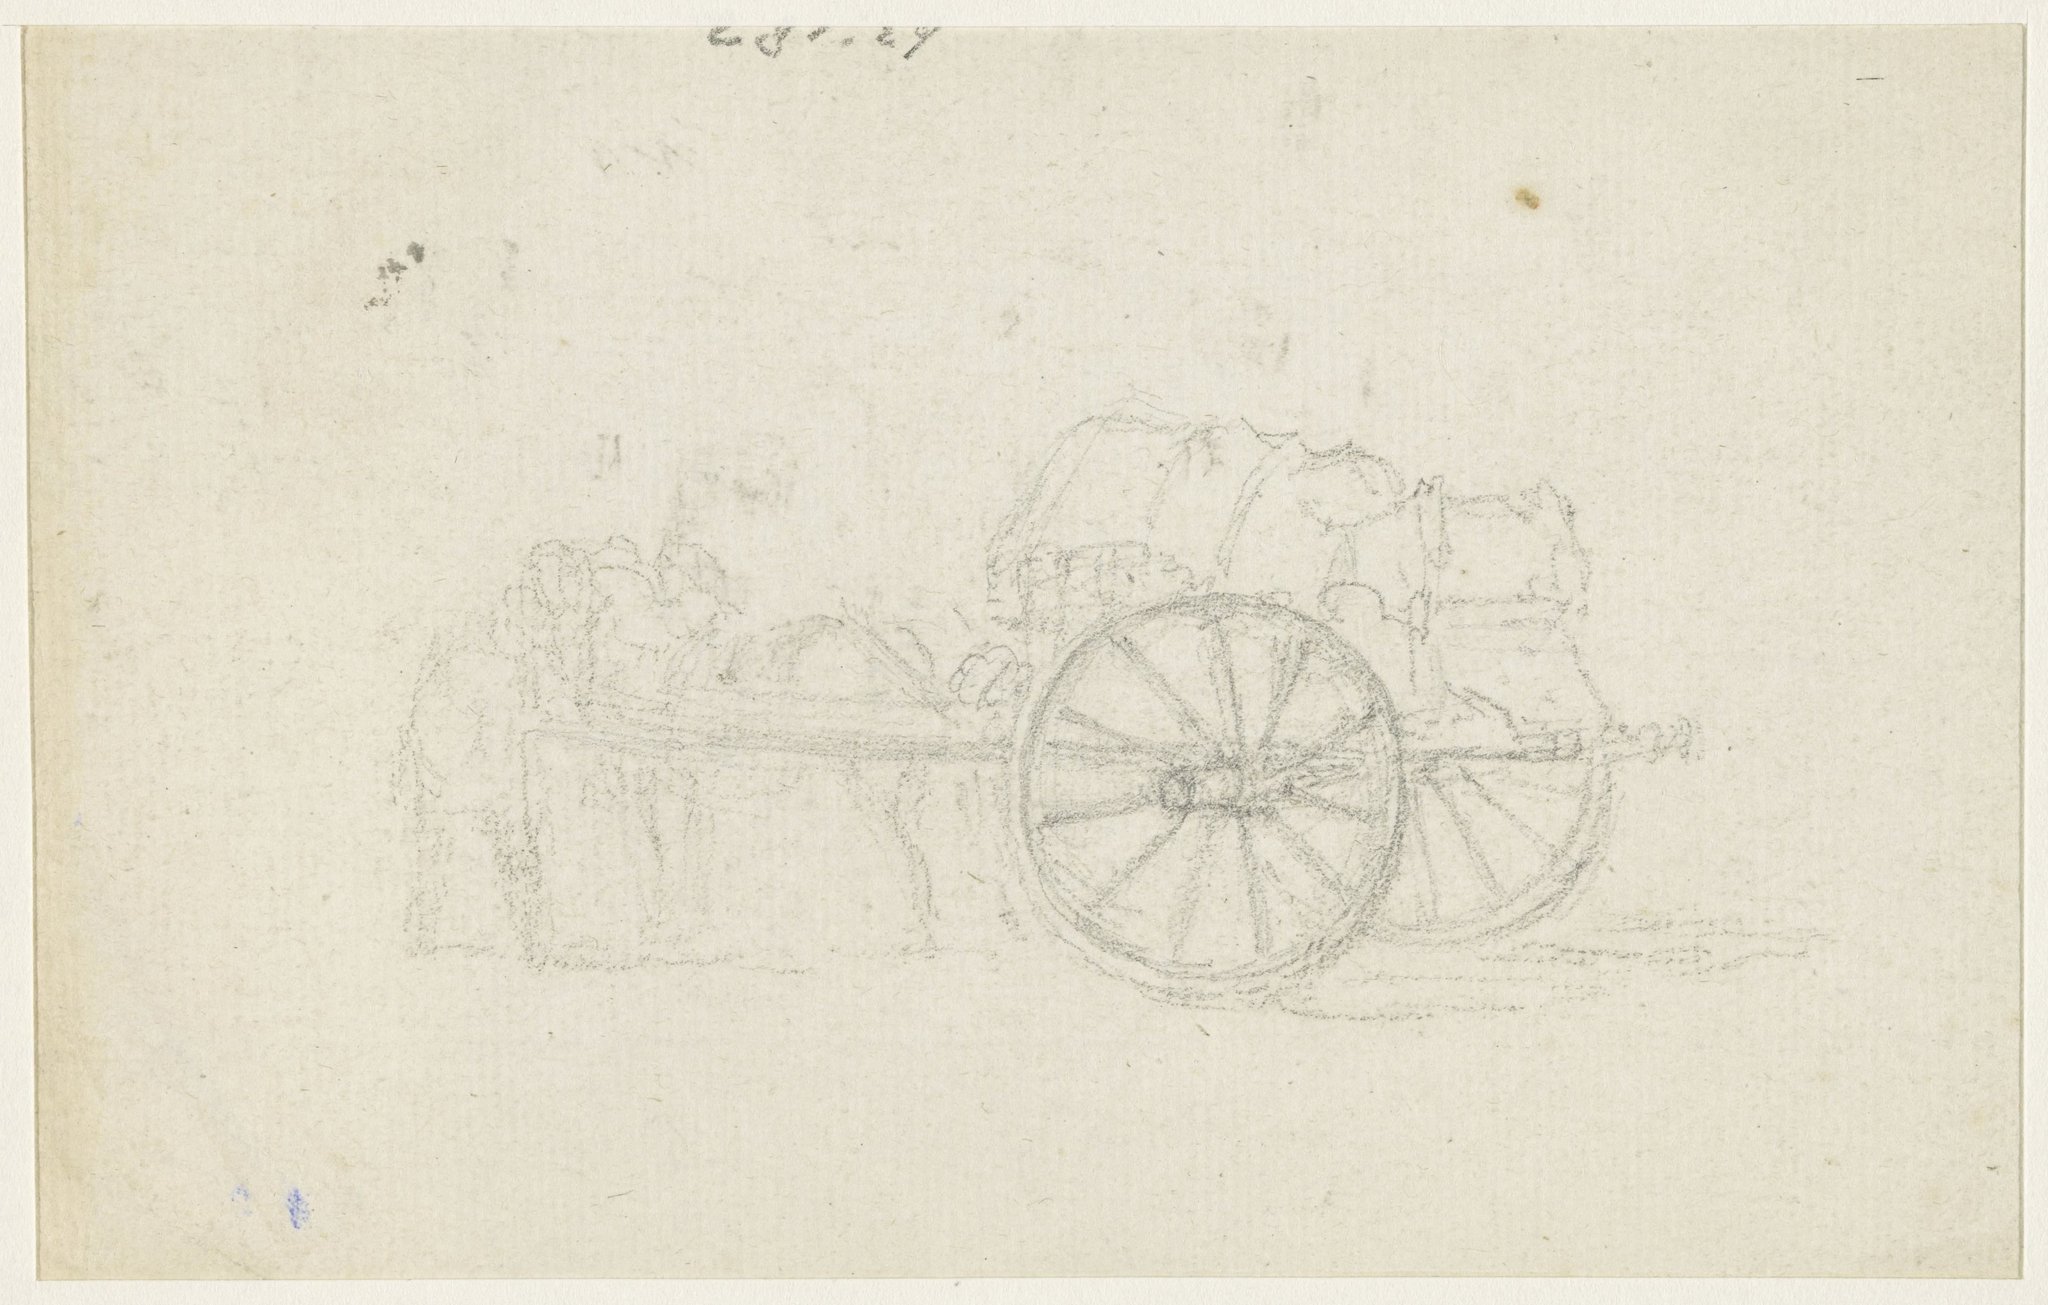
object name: drawing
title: Sleperskar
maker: georges michel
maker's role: draughtsman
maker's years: 1763-1843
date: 1773-1843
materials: paper, pencil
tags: four-wheeled vehicle drawn by one animal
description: Een van 120 tekeningen, afkomstig uit een 19e eeuws album met tekeningen van Georges Michel.